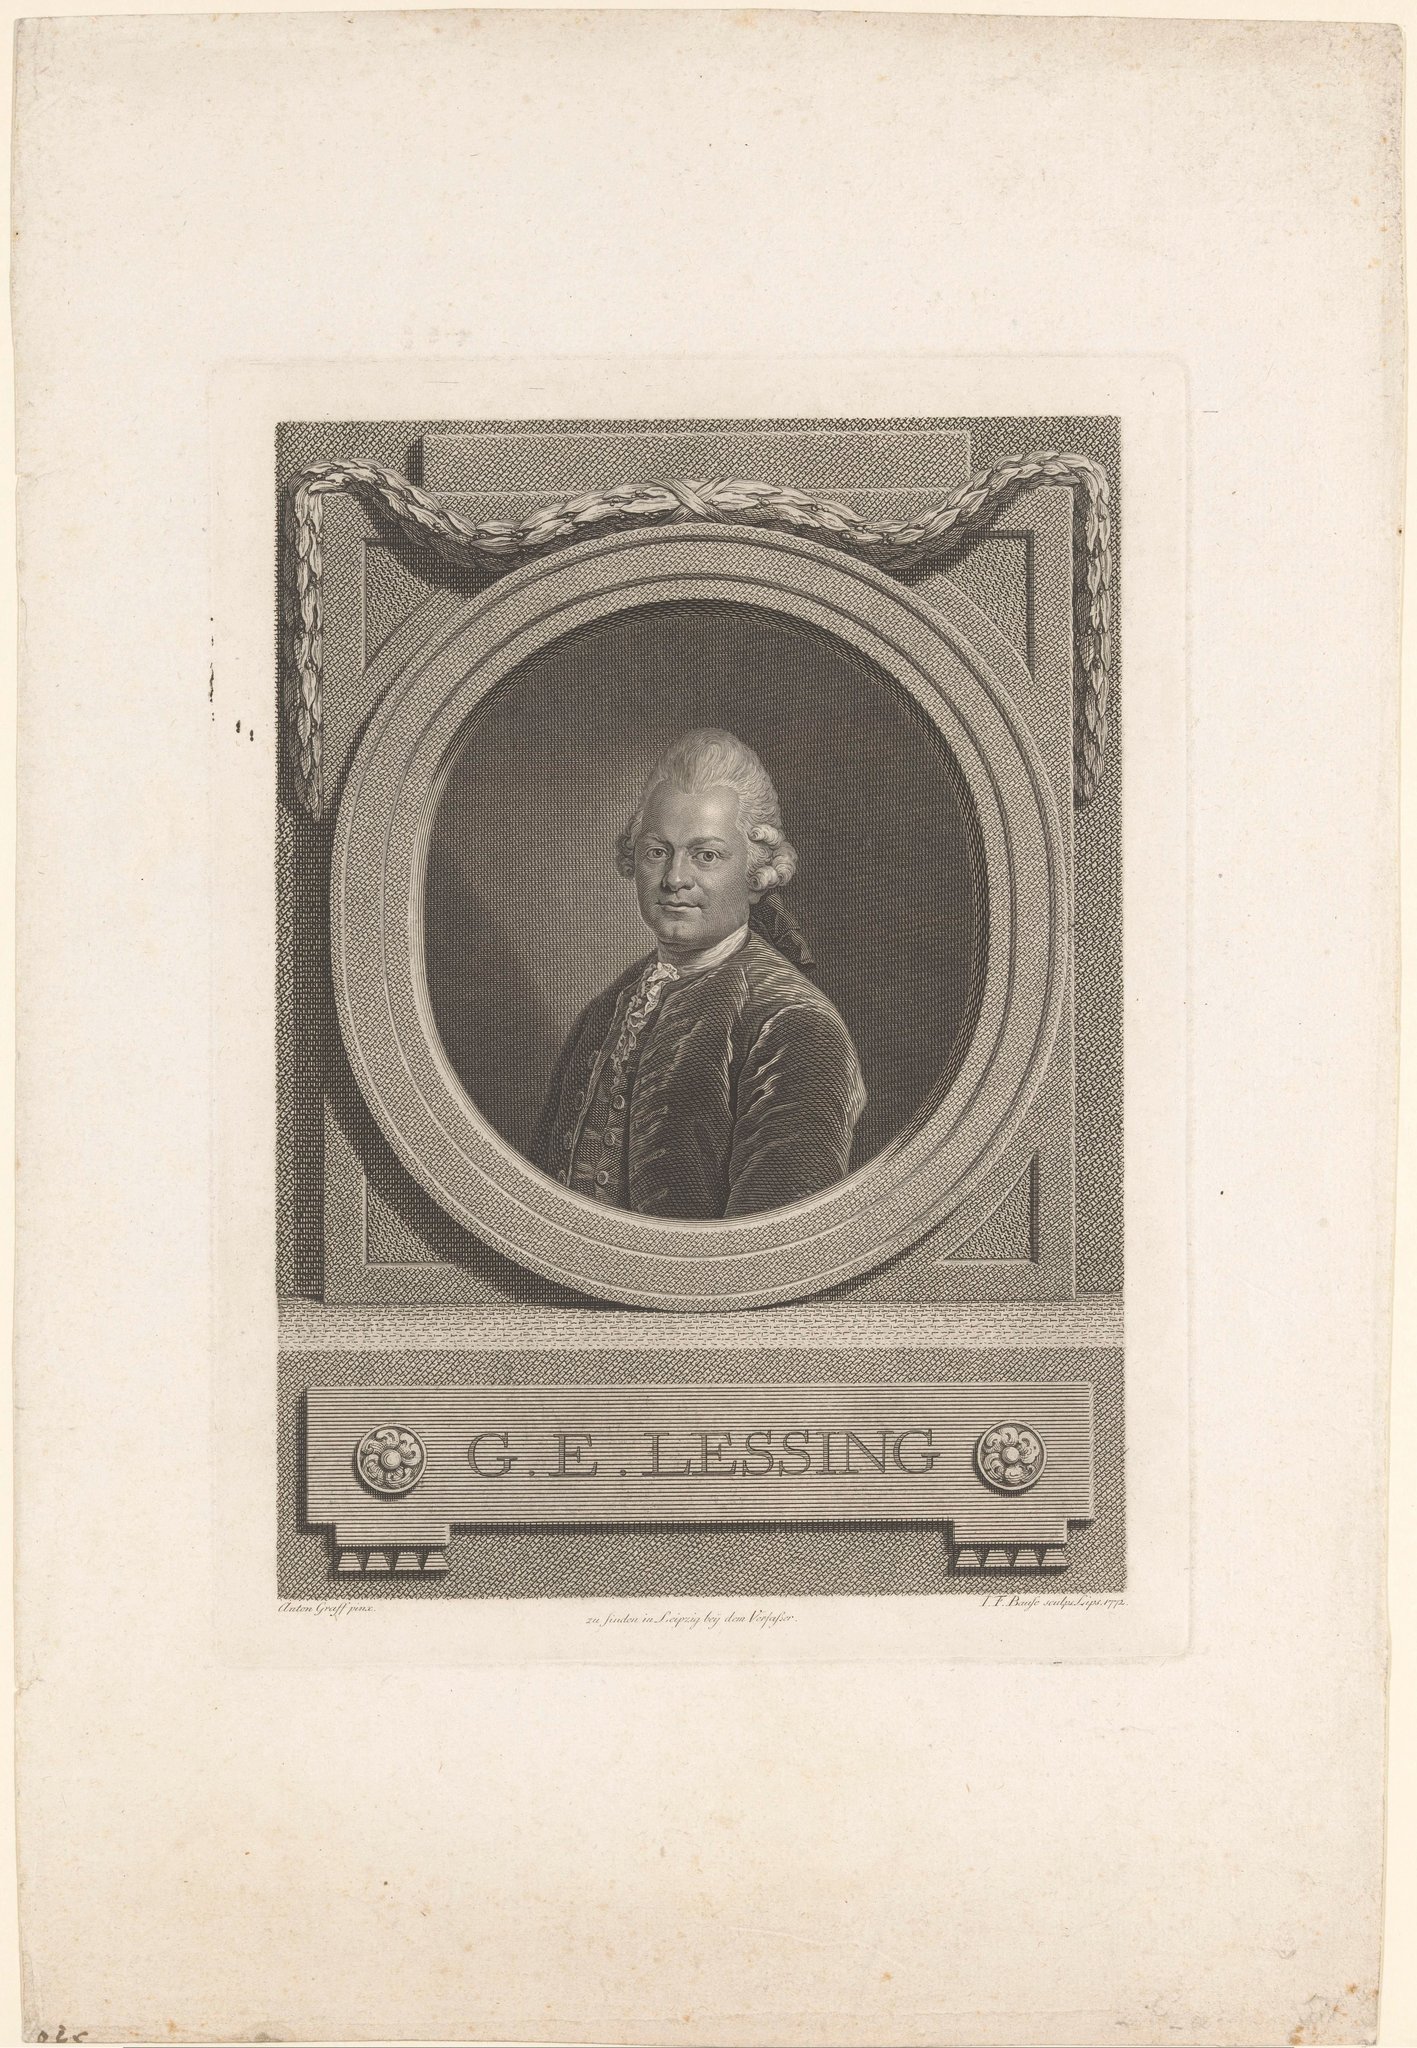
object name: print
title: Portret van Gotthold Ephraim Lessing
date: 1772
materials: paper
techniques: engraving, etching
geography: leipzig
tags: historical persons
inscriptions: collector's mark: Lugt 2228